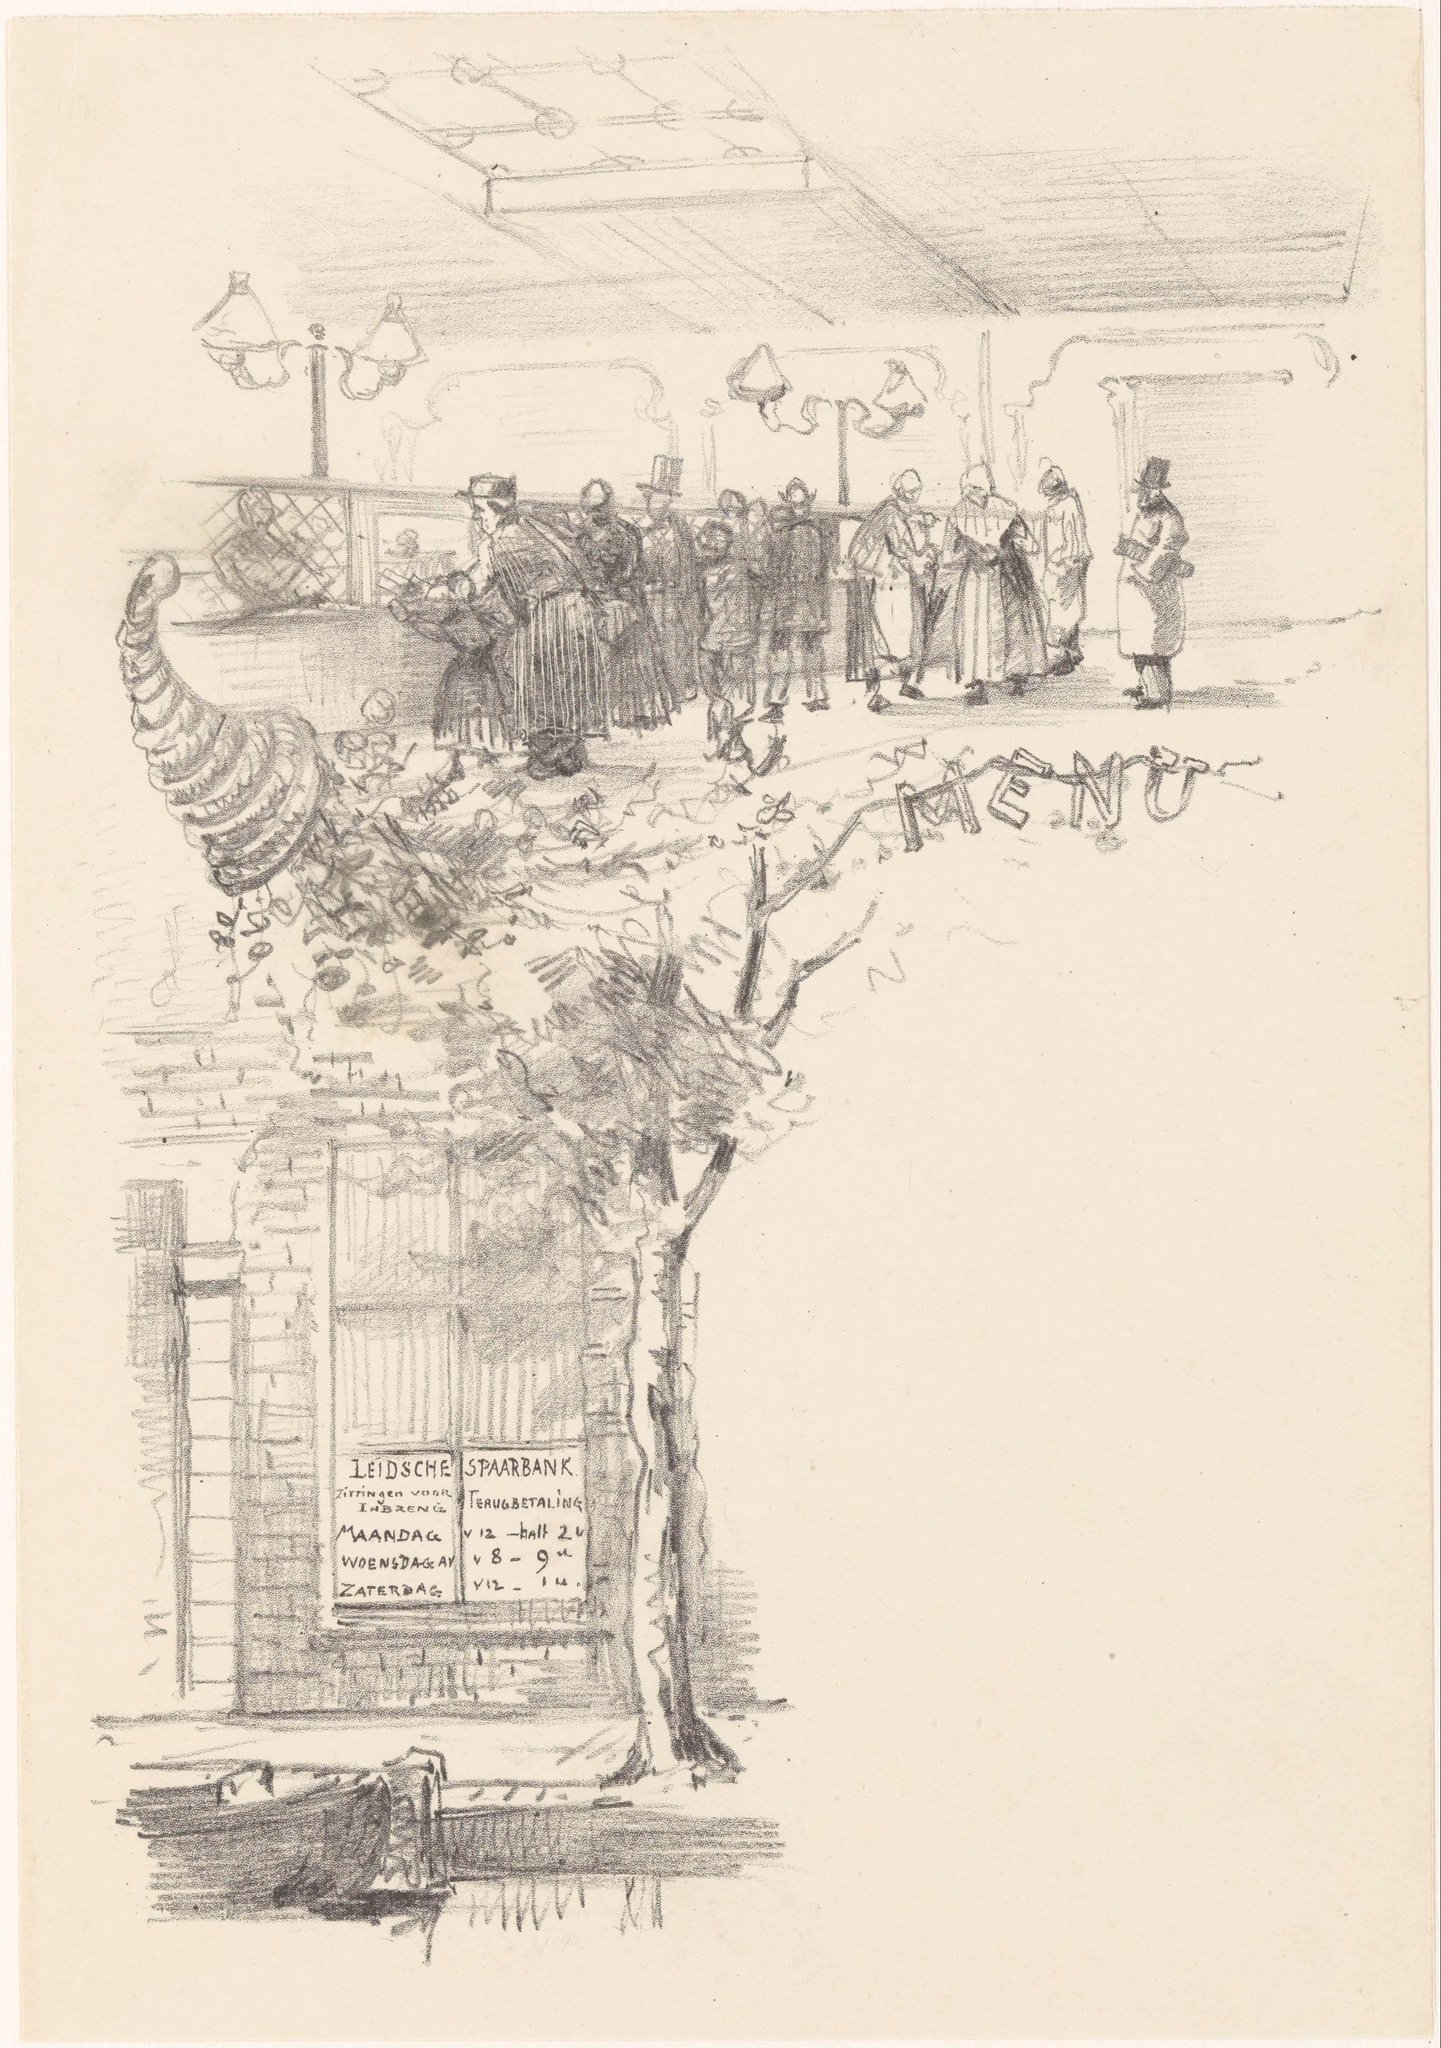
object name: print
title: Menukaart voor de Leidsche spaarbank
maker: theo van hoytema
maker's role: draughtsman, painter, print maker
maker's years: 1863-1917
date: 1878-1917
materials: paper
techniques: lithograph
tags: 'cornucopia', horn of plenty, bank, leiden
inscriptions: collector's mark: Lugt 2228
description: Bovenaan staan mensen bij loketten; rechts het woord menu. Linksonder een venster met het opschrift 'Leidsche Spaarbank'.